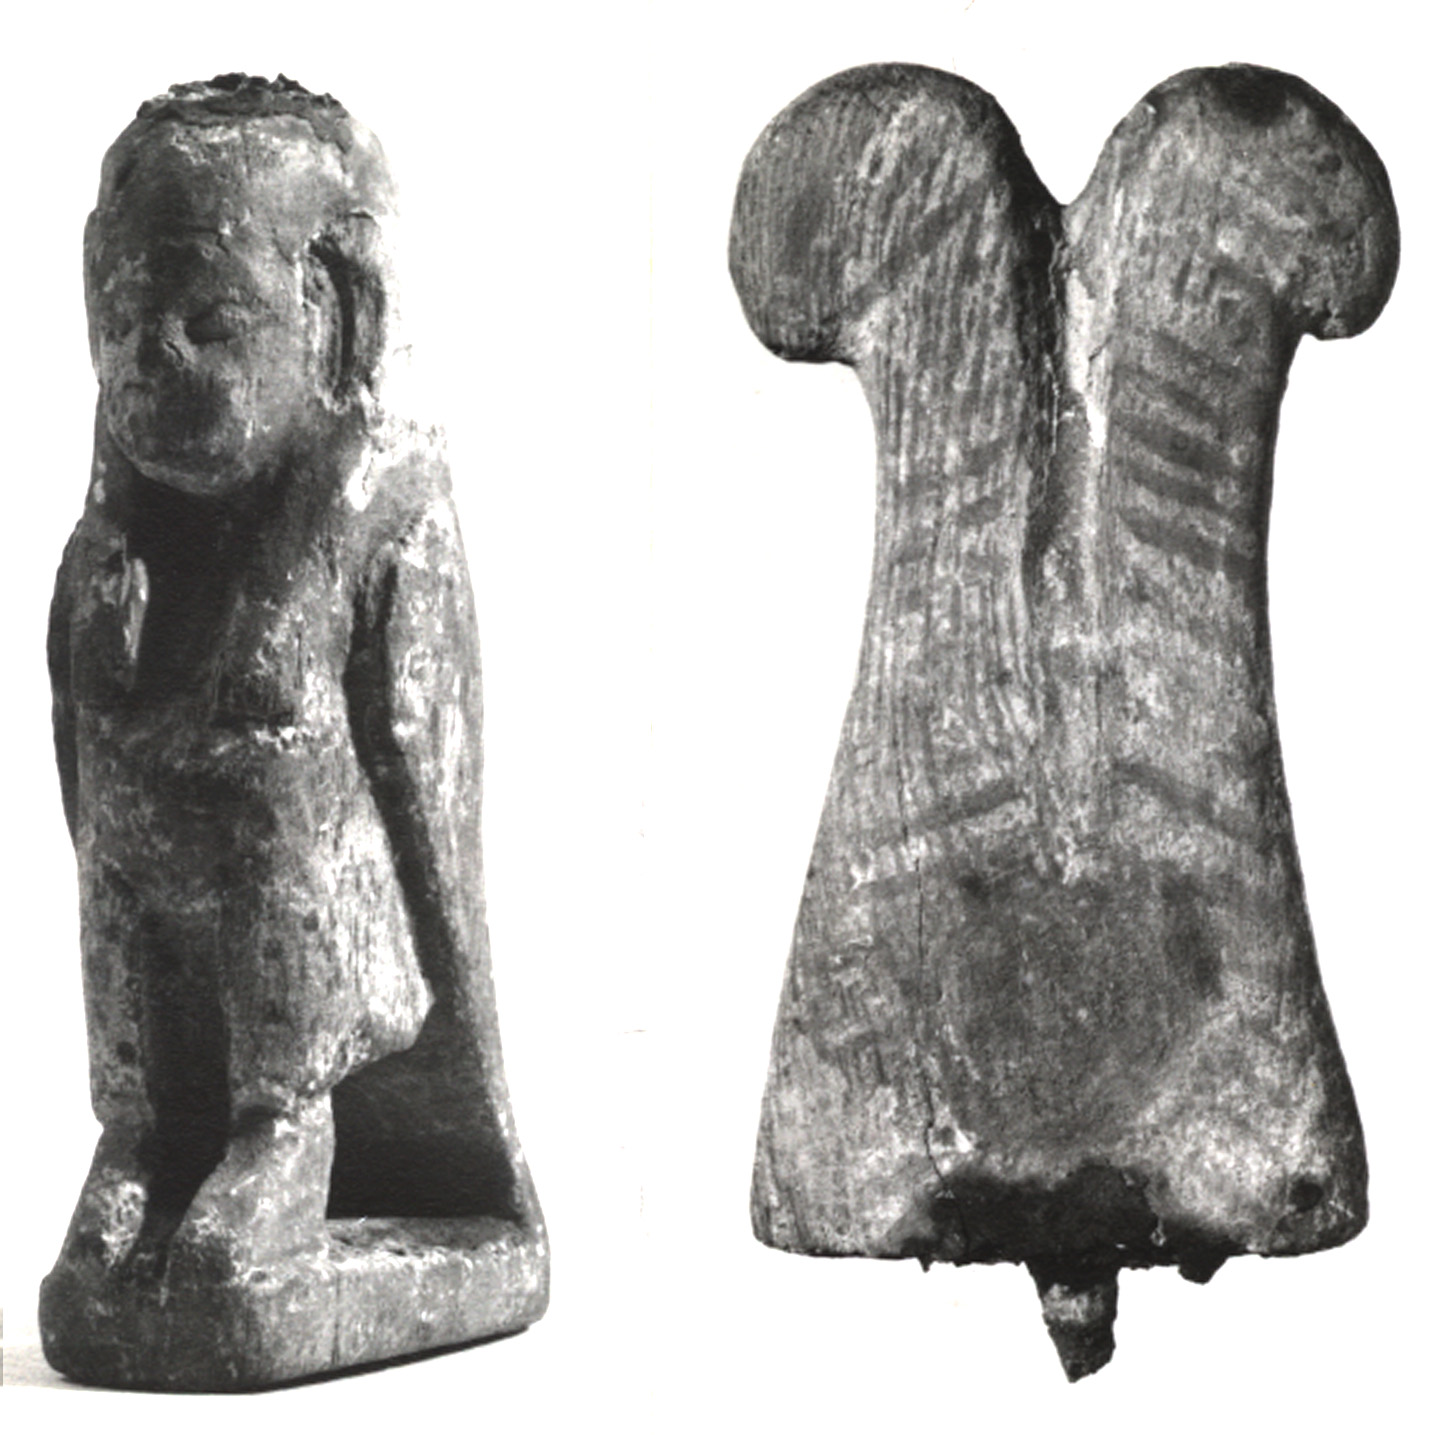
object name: figurine, ba bird, plume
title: Ba-Bird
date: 712-343 BCE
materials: paint, wood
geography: southern upper egypt